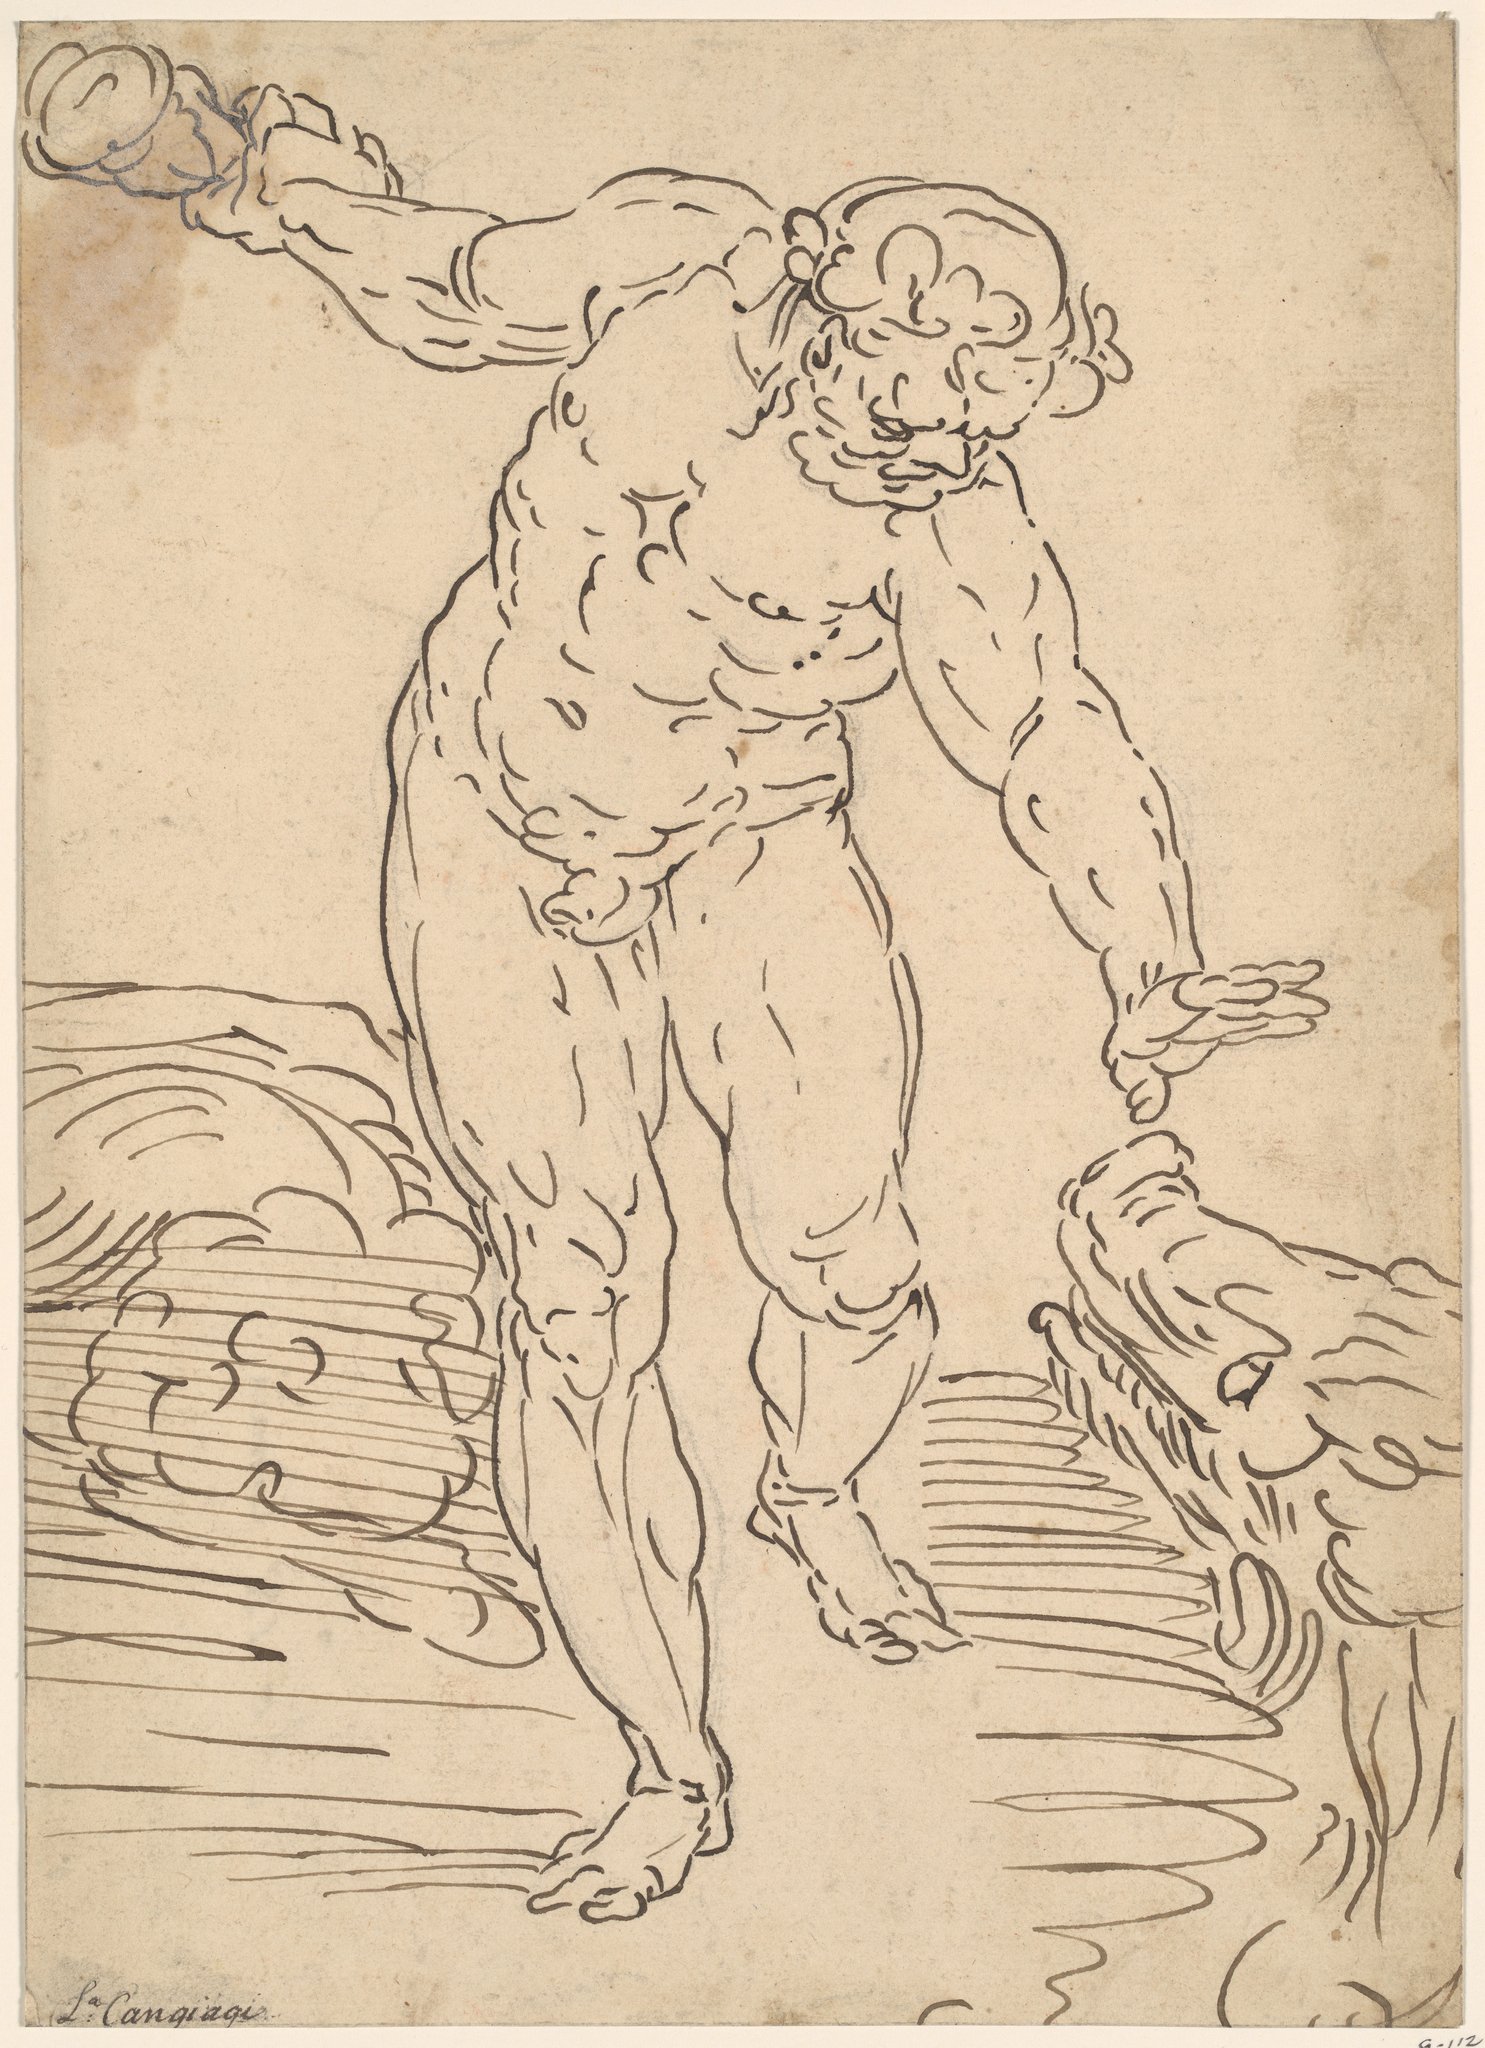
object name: drawing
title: Hercules and the Erymanthian Boar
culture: italian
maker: school of cambiaso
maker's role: artist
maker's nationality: italian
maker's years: 1527-1585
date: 1550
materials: chalk, ink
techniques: pen, drawing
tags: male nudes,hercules,boars